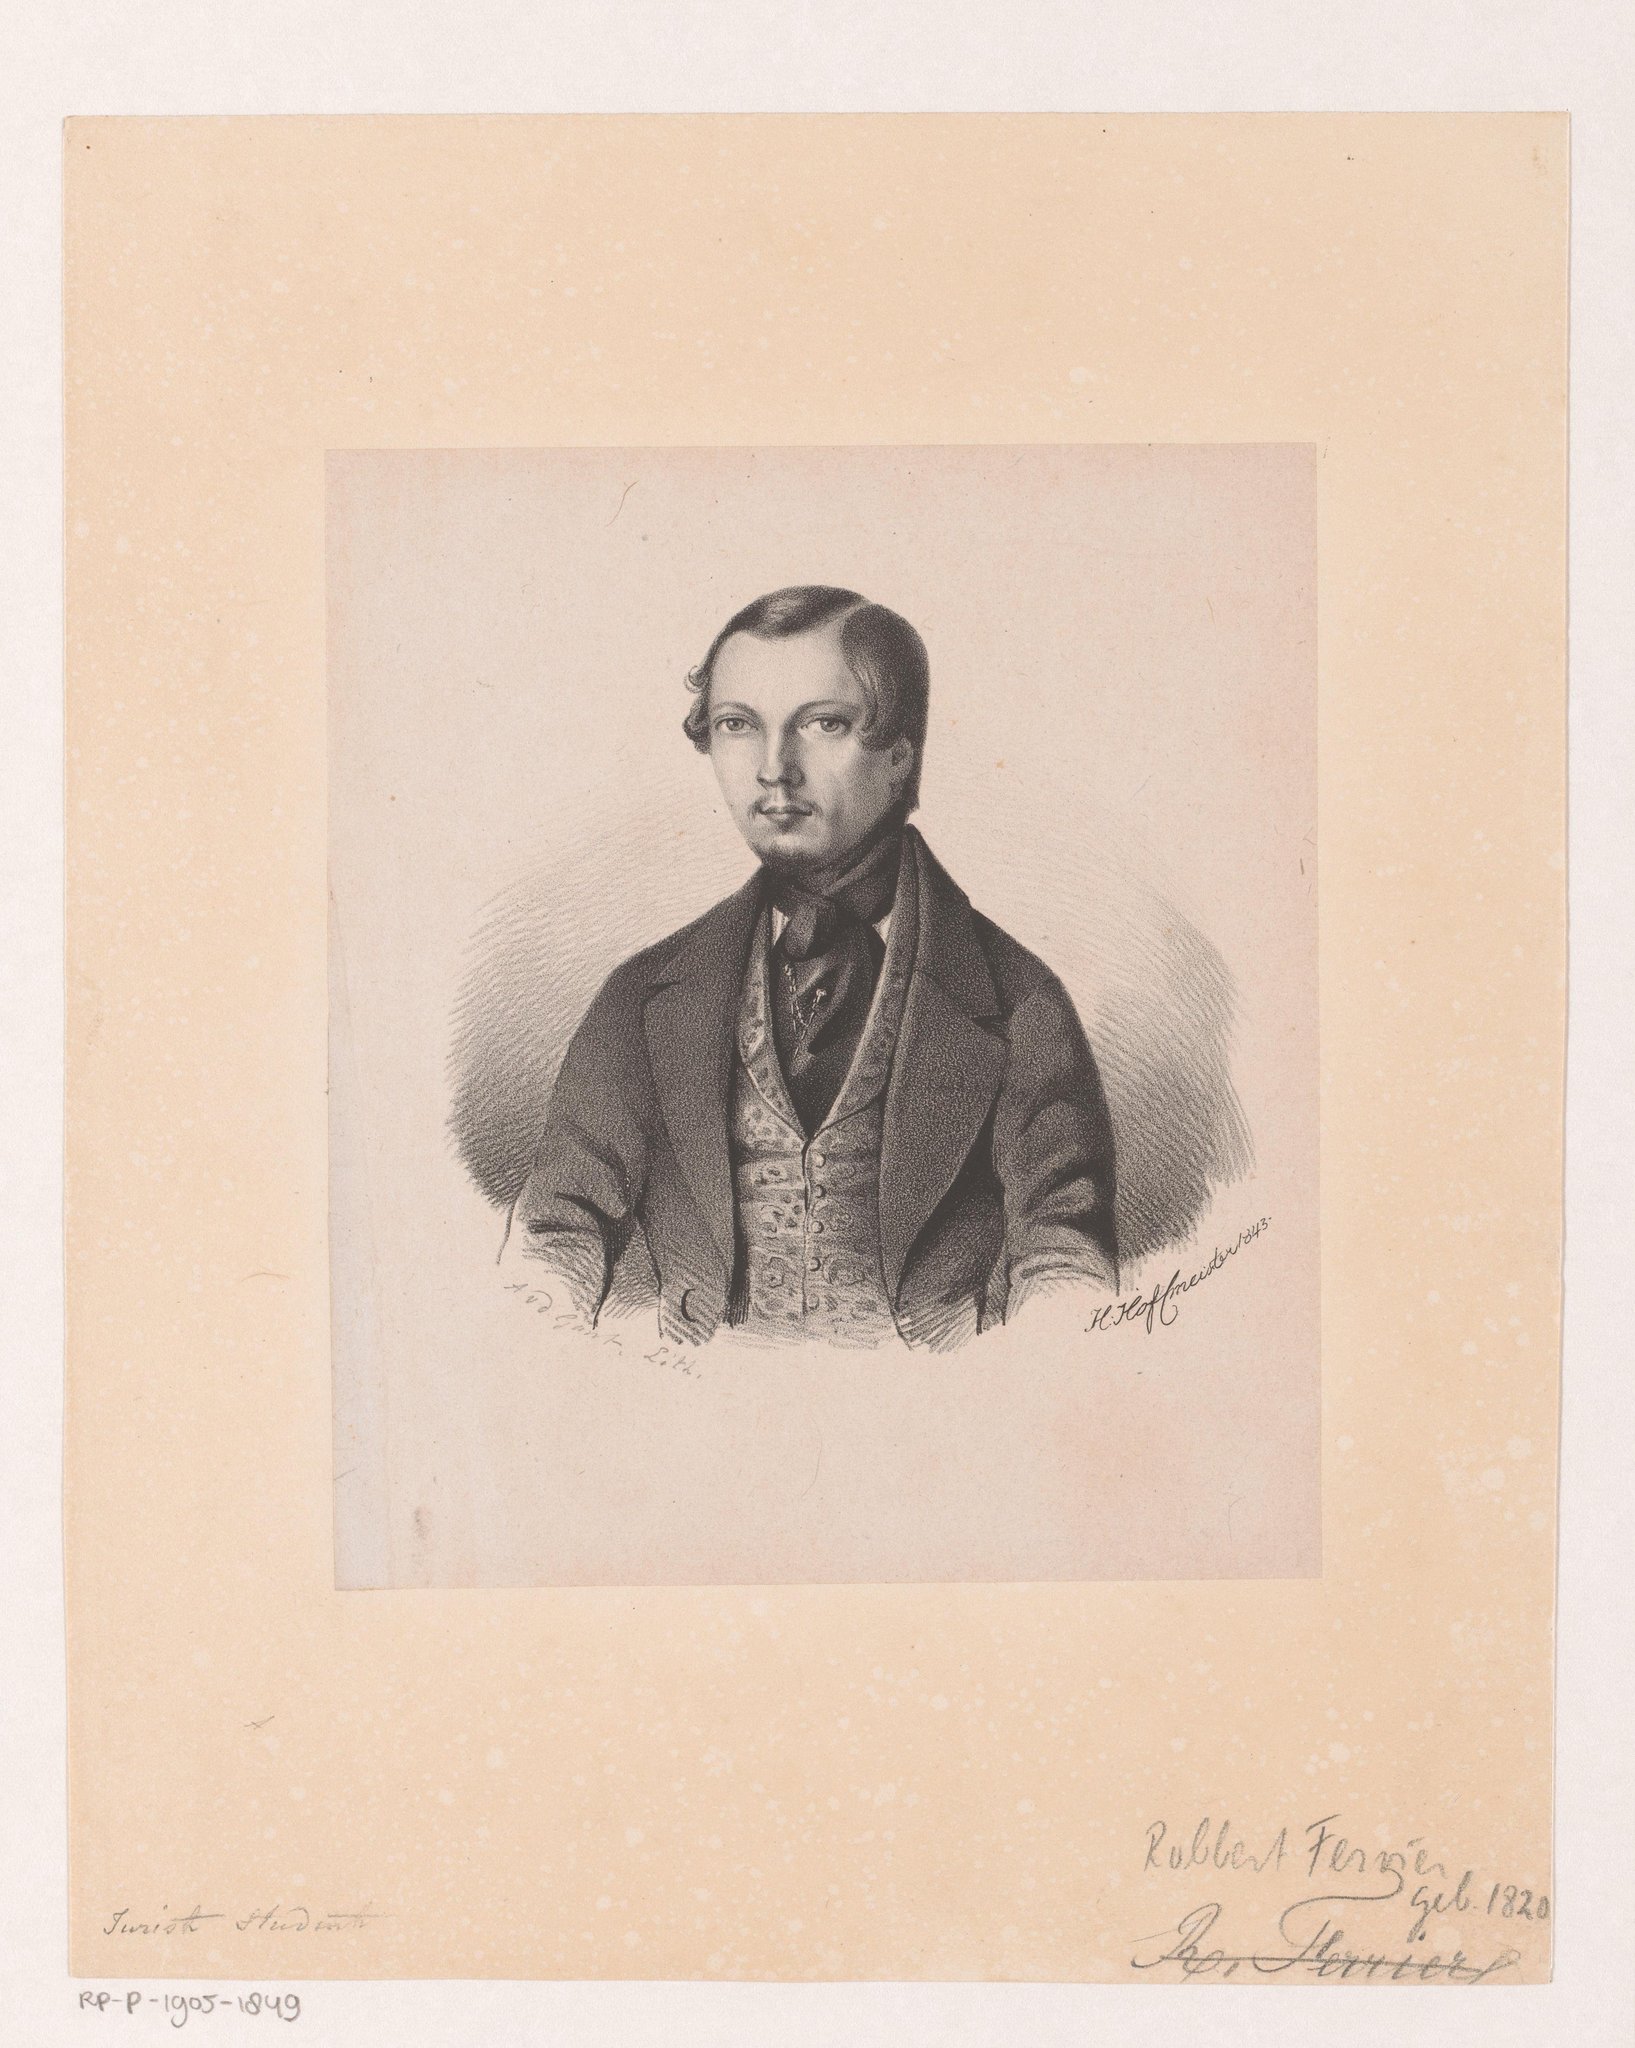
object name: print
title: Portret van student R. Fervier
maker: johan hendrik hoffmeister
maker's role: print maker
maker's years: 1823-1904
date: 1843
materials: paper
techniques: lithograph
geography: netherlands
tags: historical persons (+ (full) bust portrait)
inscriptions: collector's mark: Lugt 2228